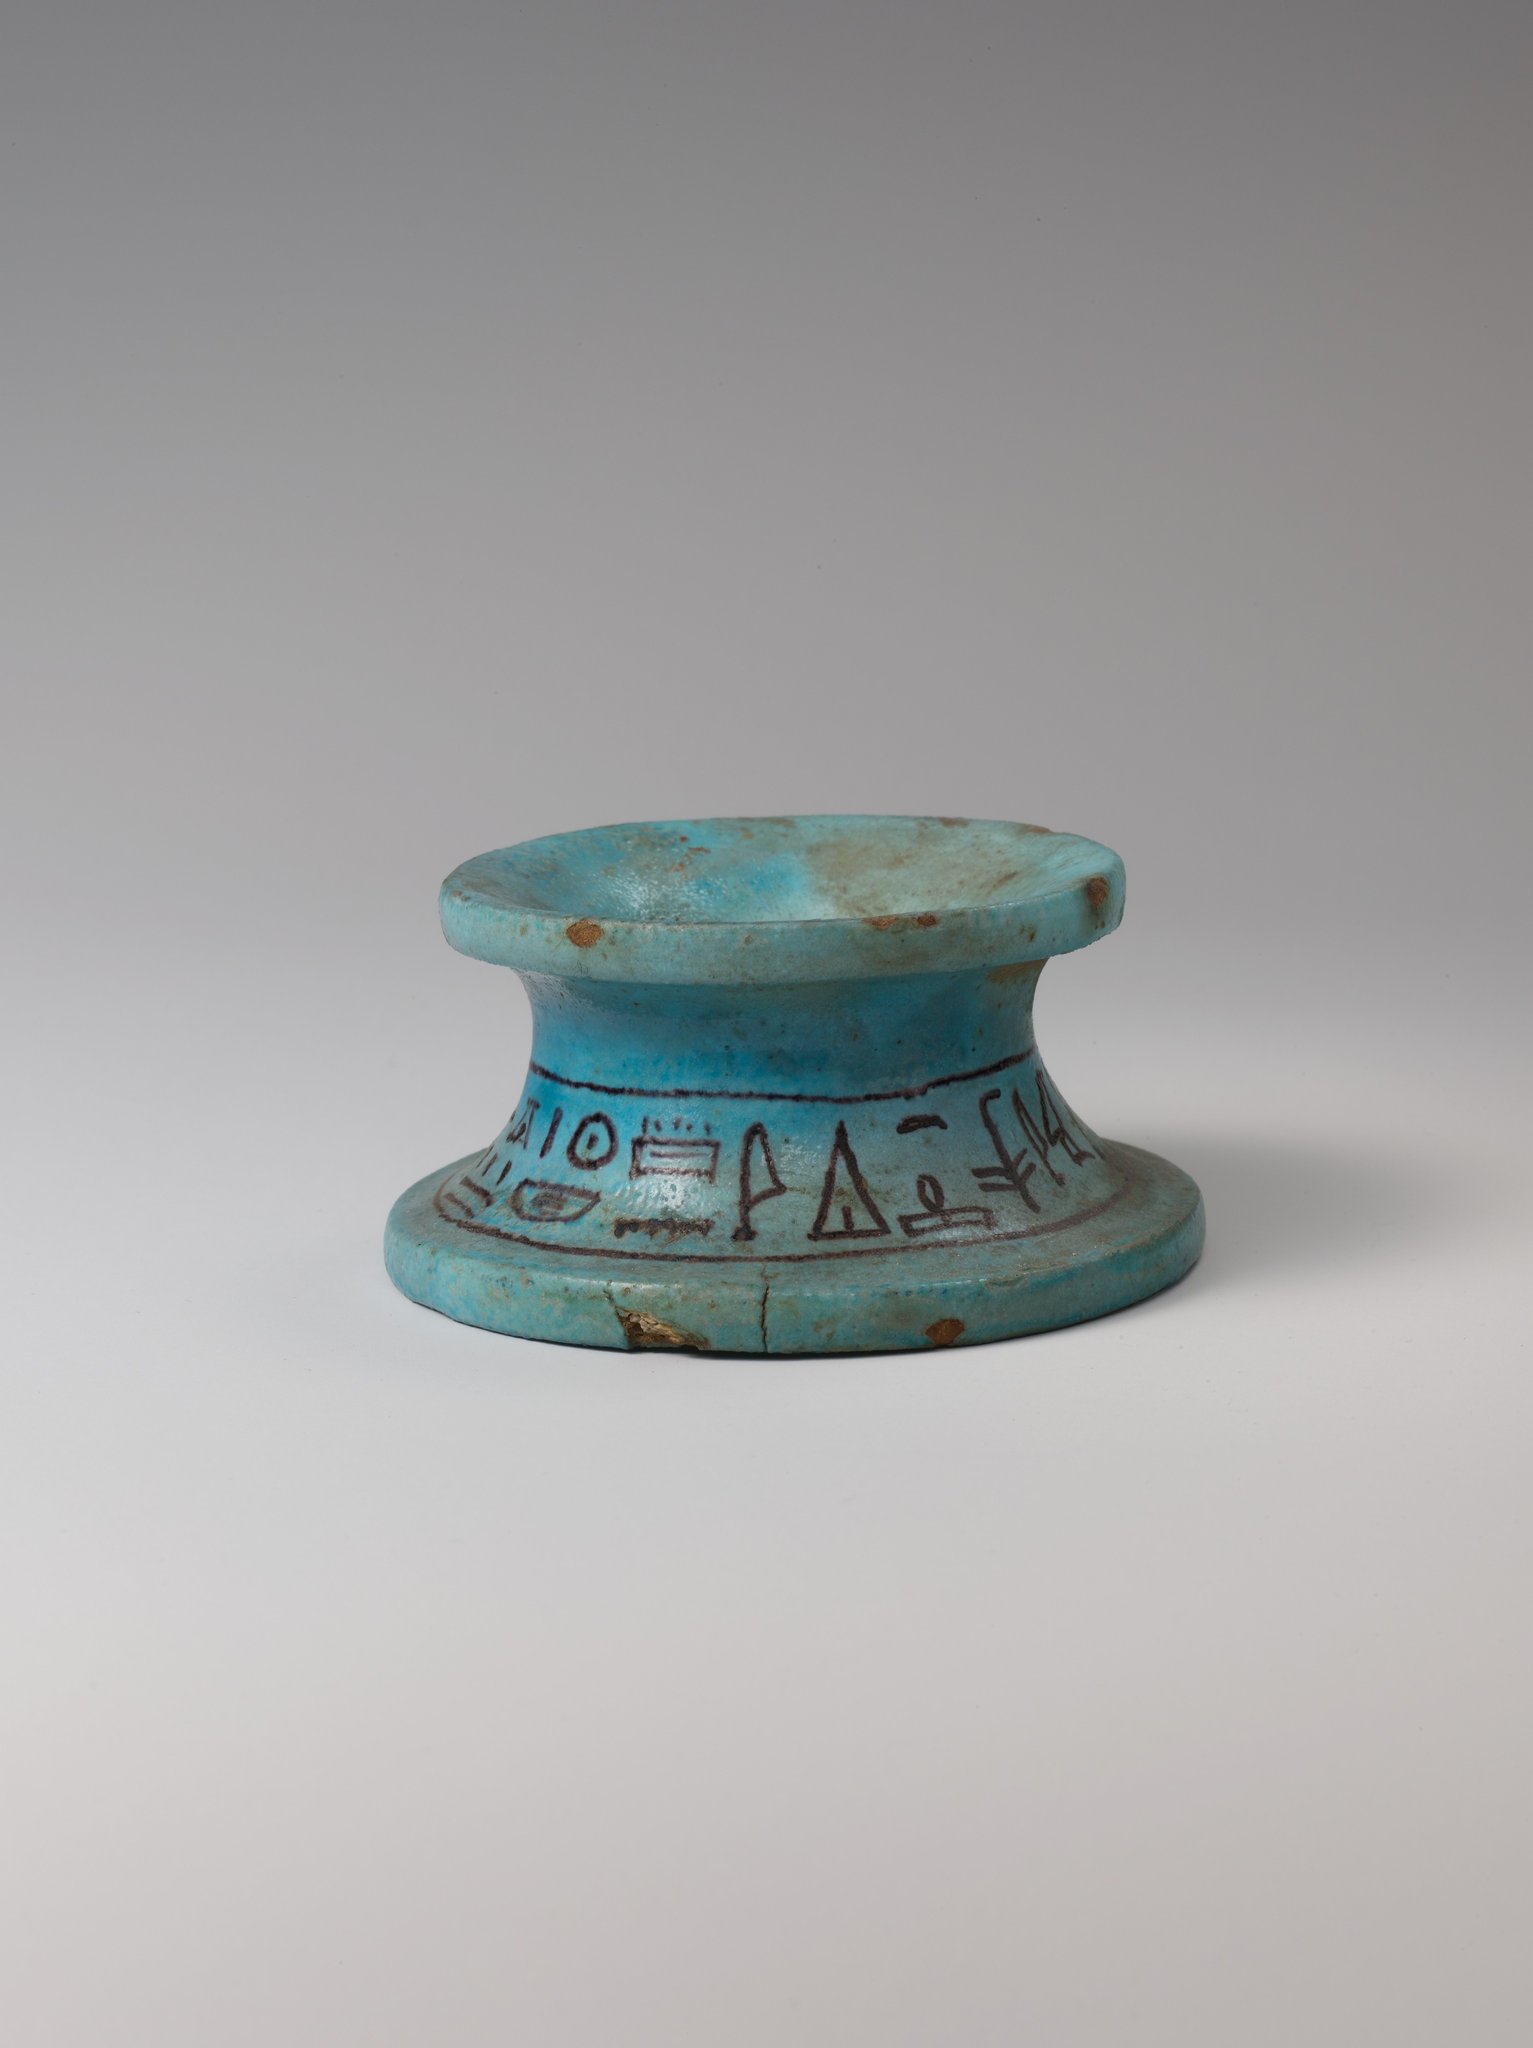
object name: vessel stand, scribe iui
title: Vessel stand naming the scribe Iui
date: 1550-1295 BCE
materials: faience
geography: egypt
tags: hieroglyphs